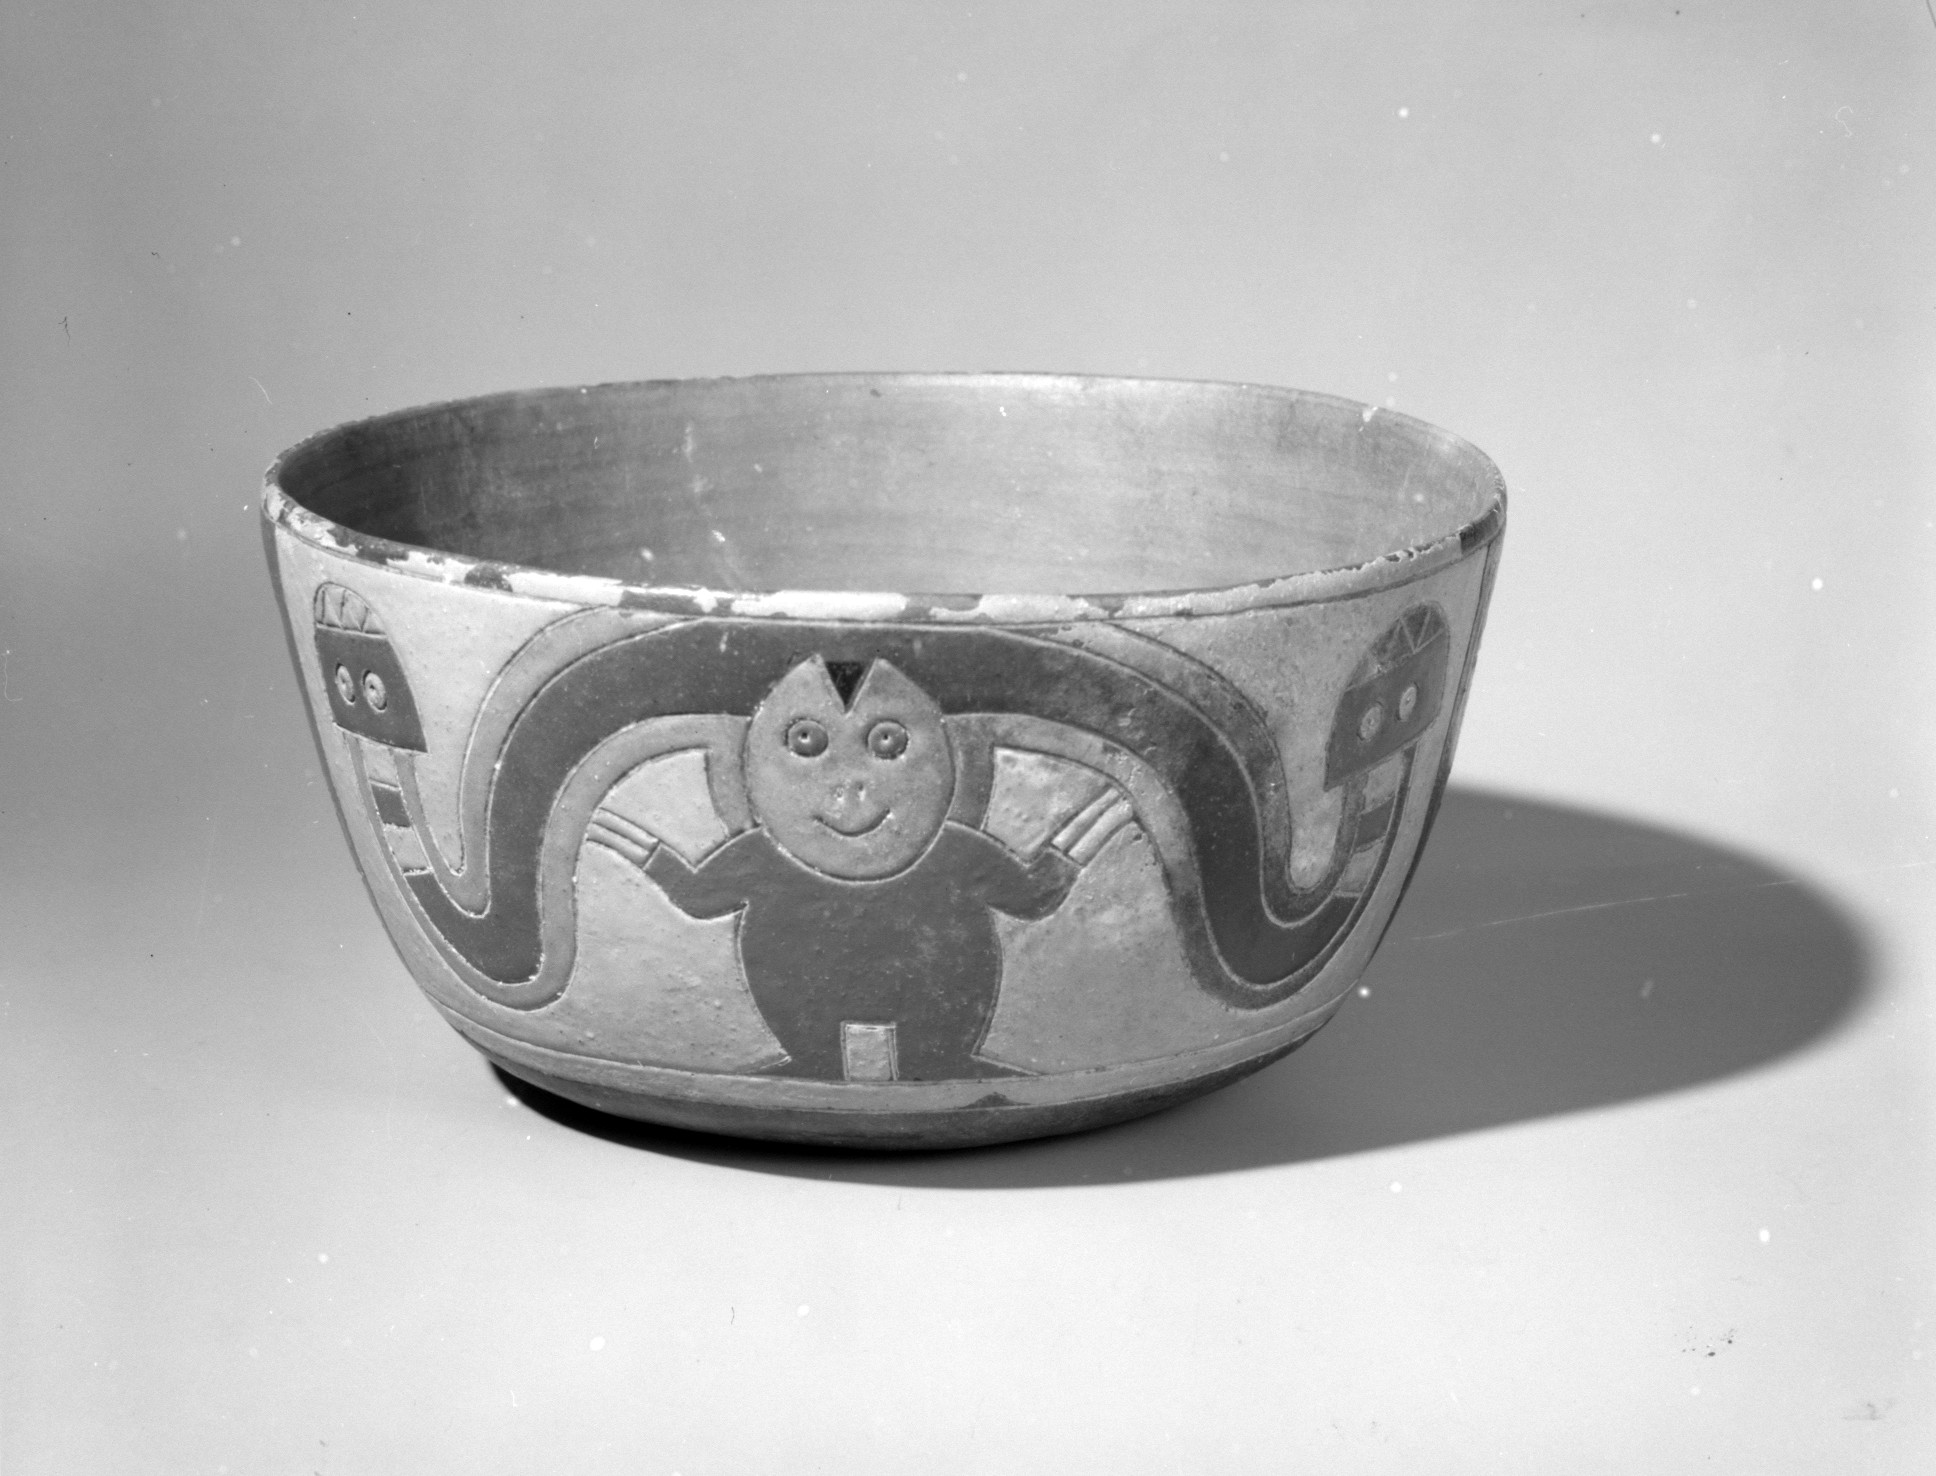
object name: bowl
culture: paracas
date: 200-1 BCE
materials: ceramic, paint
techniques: firing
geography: peru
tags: human figures